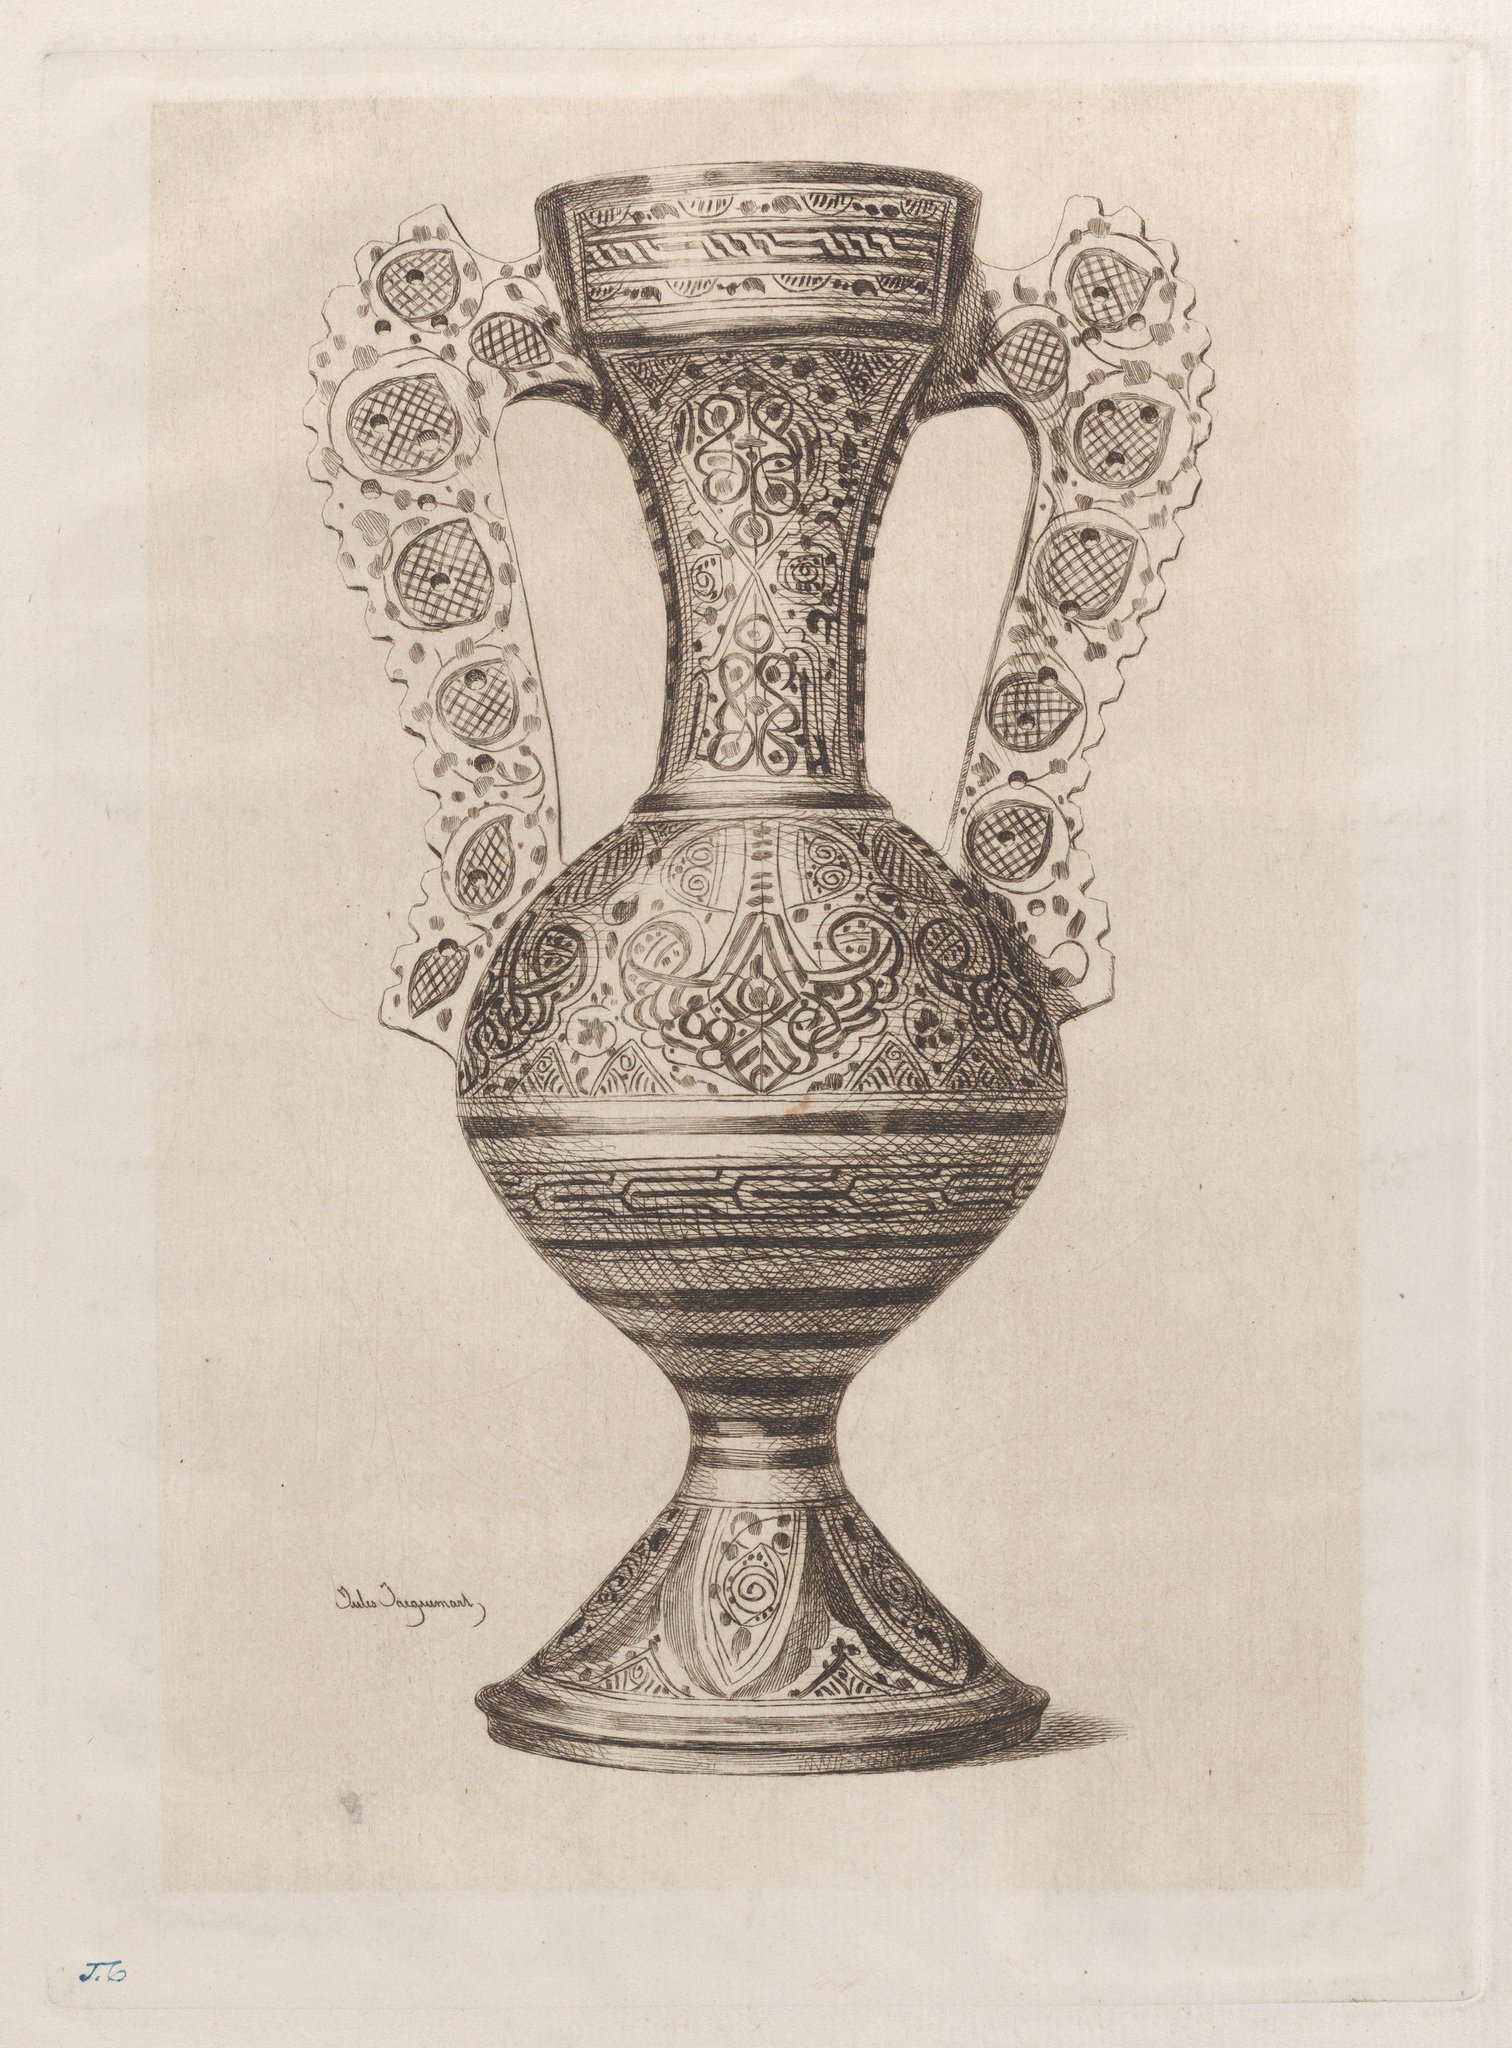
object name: print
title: Spanish Vase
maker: jules-ferdinand jacquemart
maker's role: artist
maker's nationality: french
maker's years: 1837-1880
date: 1862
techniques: etching